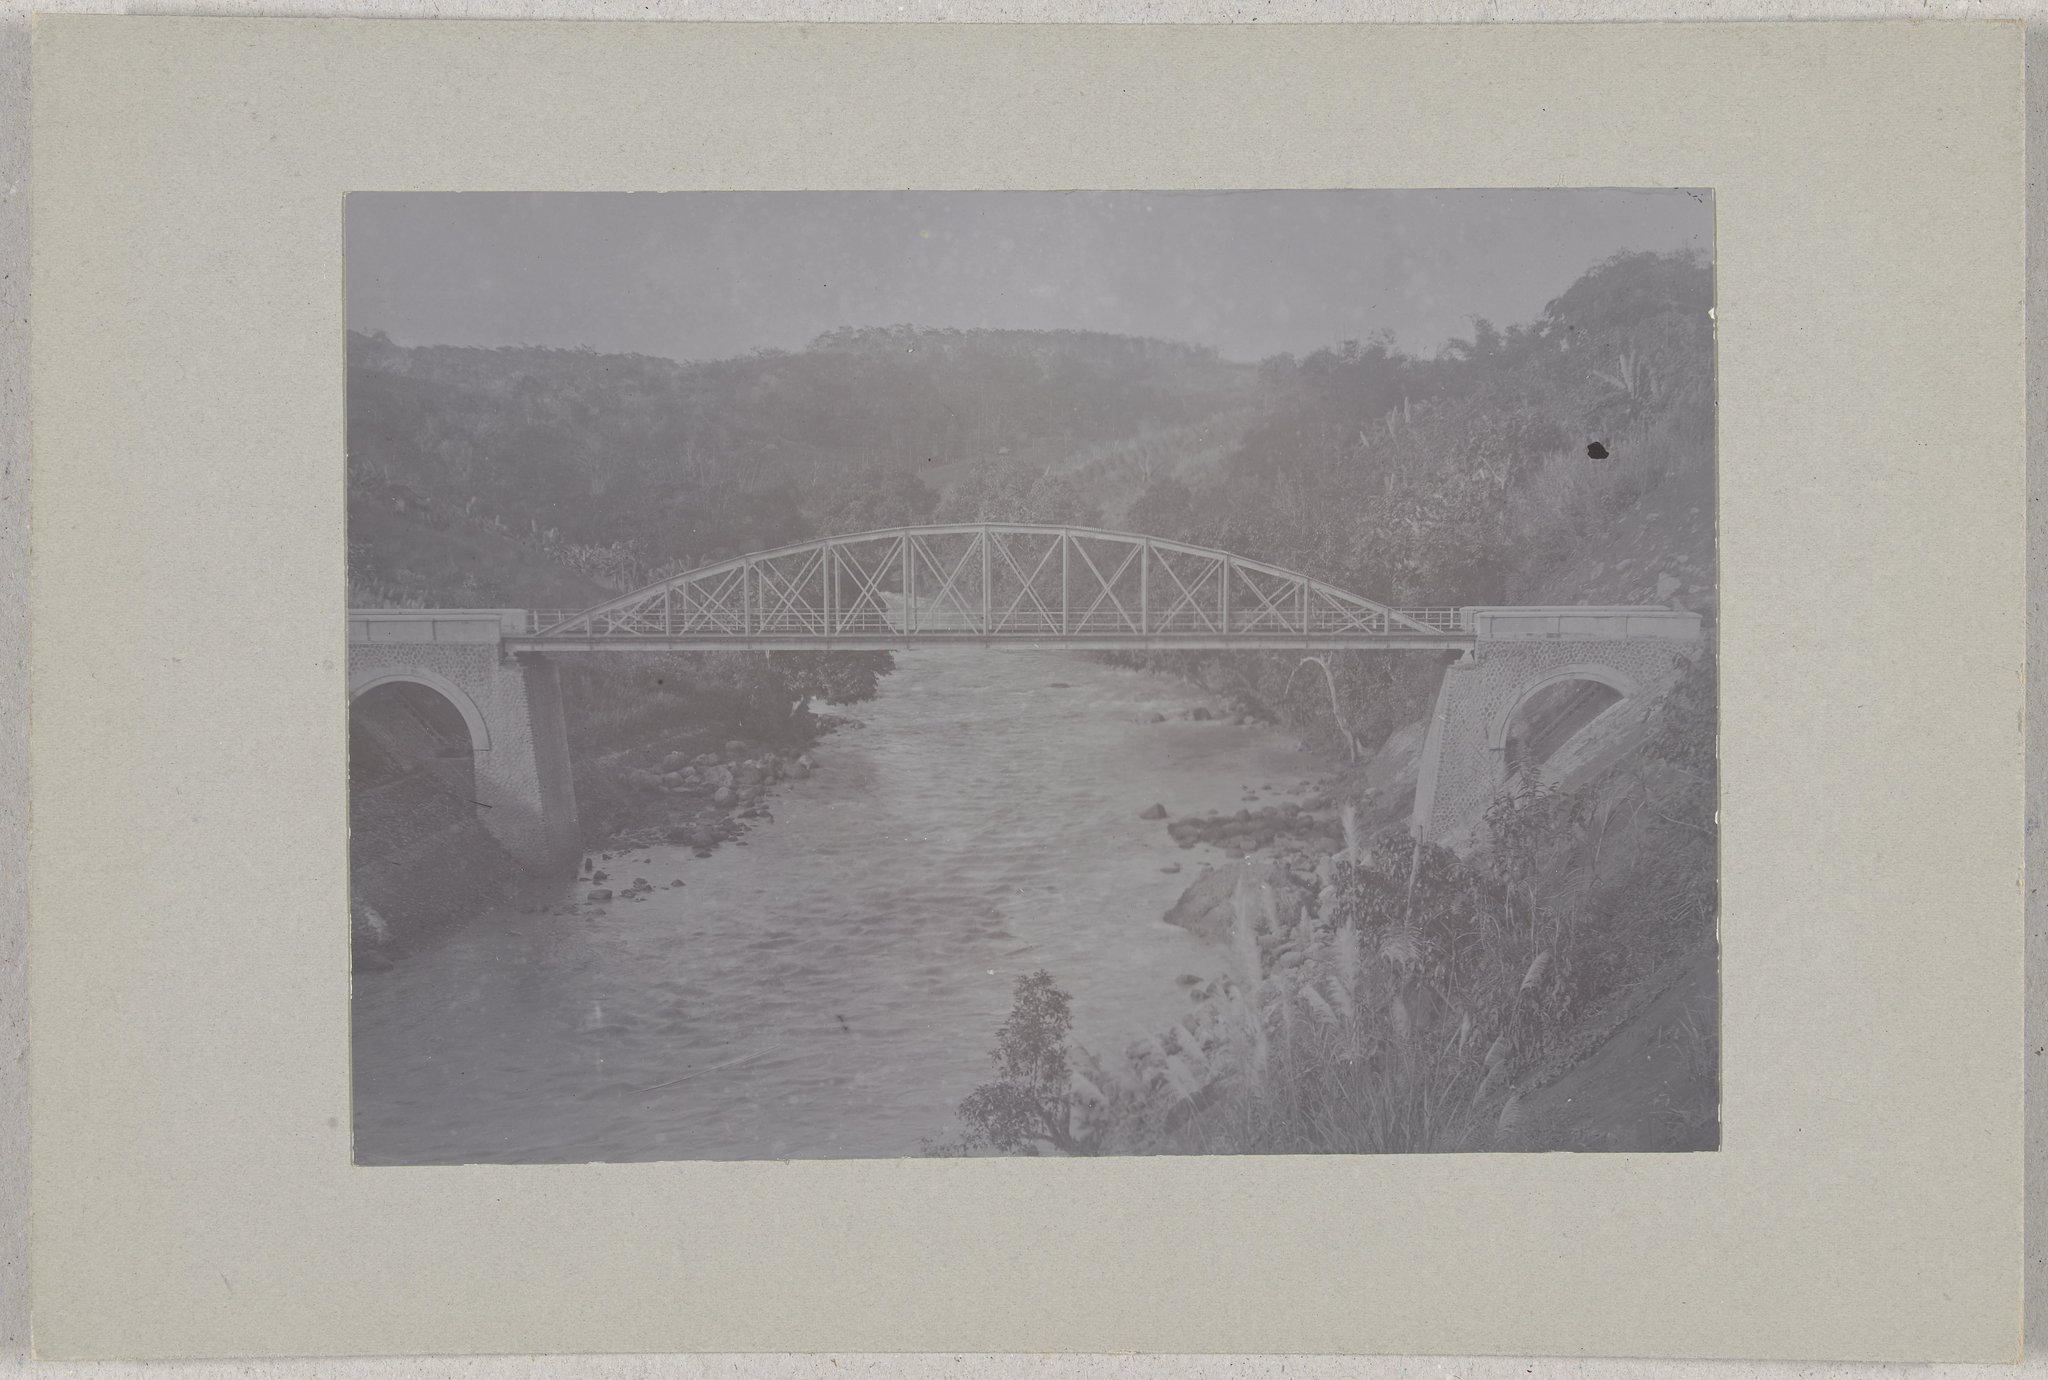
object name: photograph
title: 56a Op weg naar Wijnkoopsbaai ('2a Brug in de Anei-kloof' is doorgestreept)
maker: Anonymous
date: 1895-1915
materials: cardboard, paper, photographic support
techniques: gelatin silver print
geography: java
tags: indonesia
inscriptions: annotation: ‘56a Op weg naar Wijnkoopsbaai ('2a Brug in de Anei-kloof' is doorgestreept)’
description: Brug over een rivier, op weg naar de Wijnkoopsbaai, Java, Nederlands-Indië